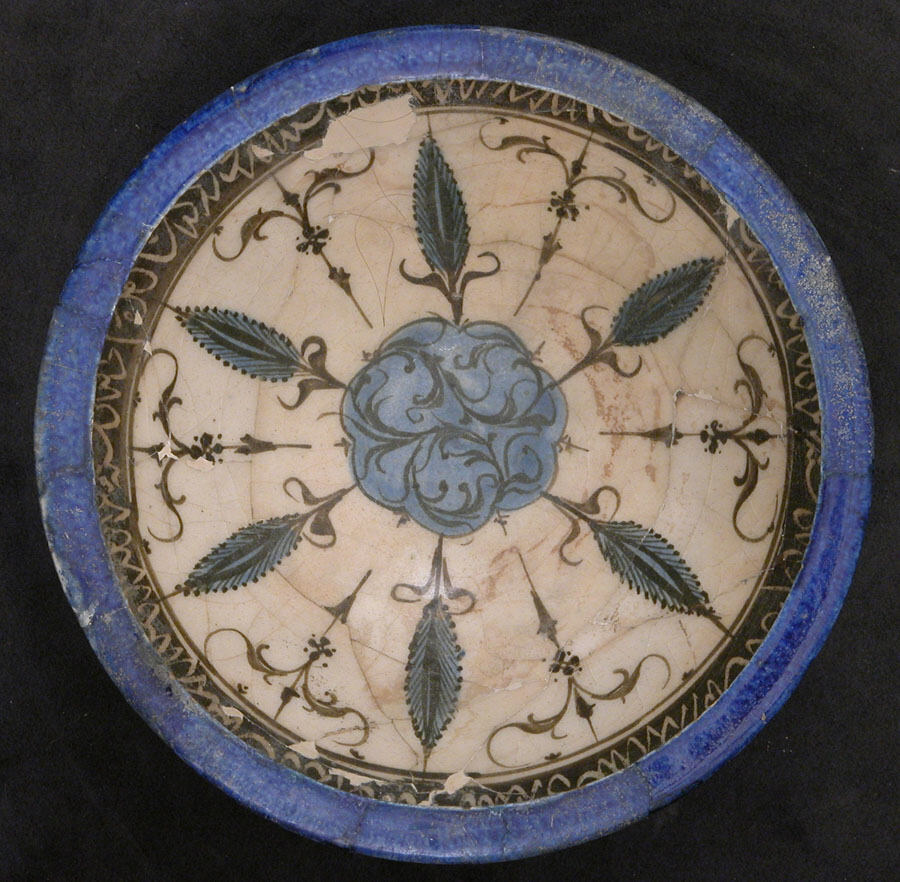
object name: bowl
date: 1201-1300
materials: stonepaste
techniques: painting, underglaze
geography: iran